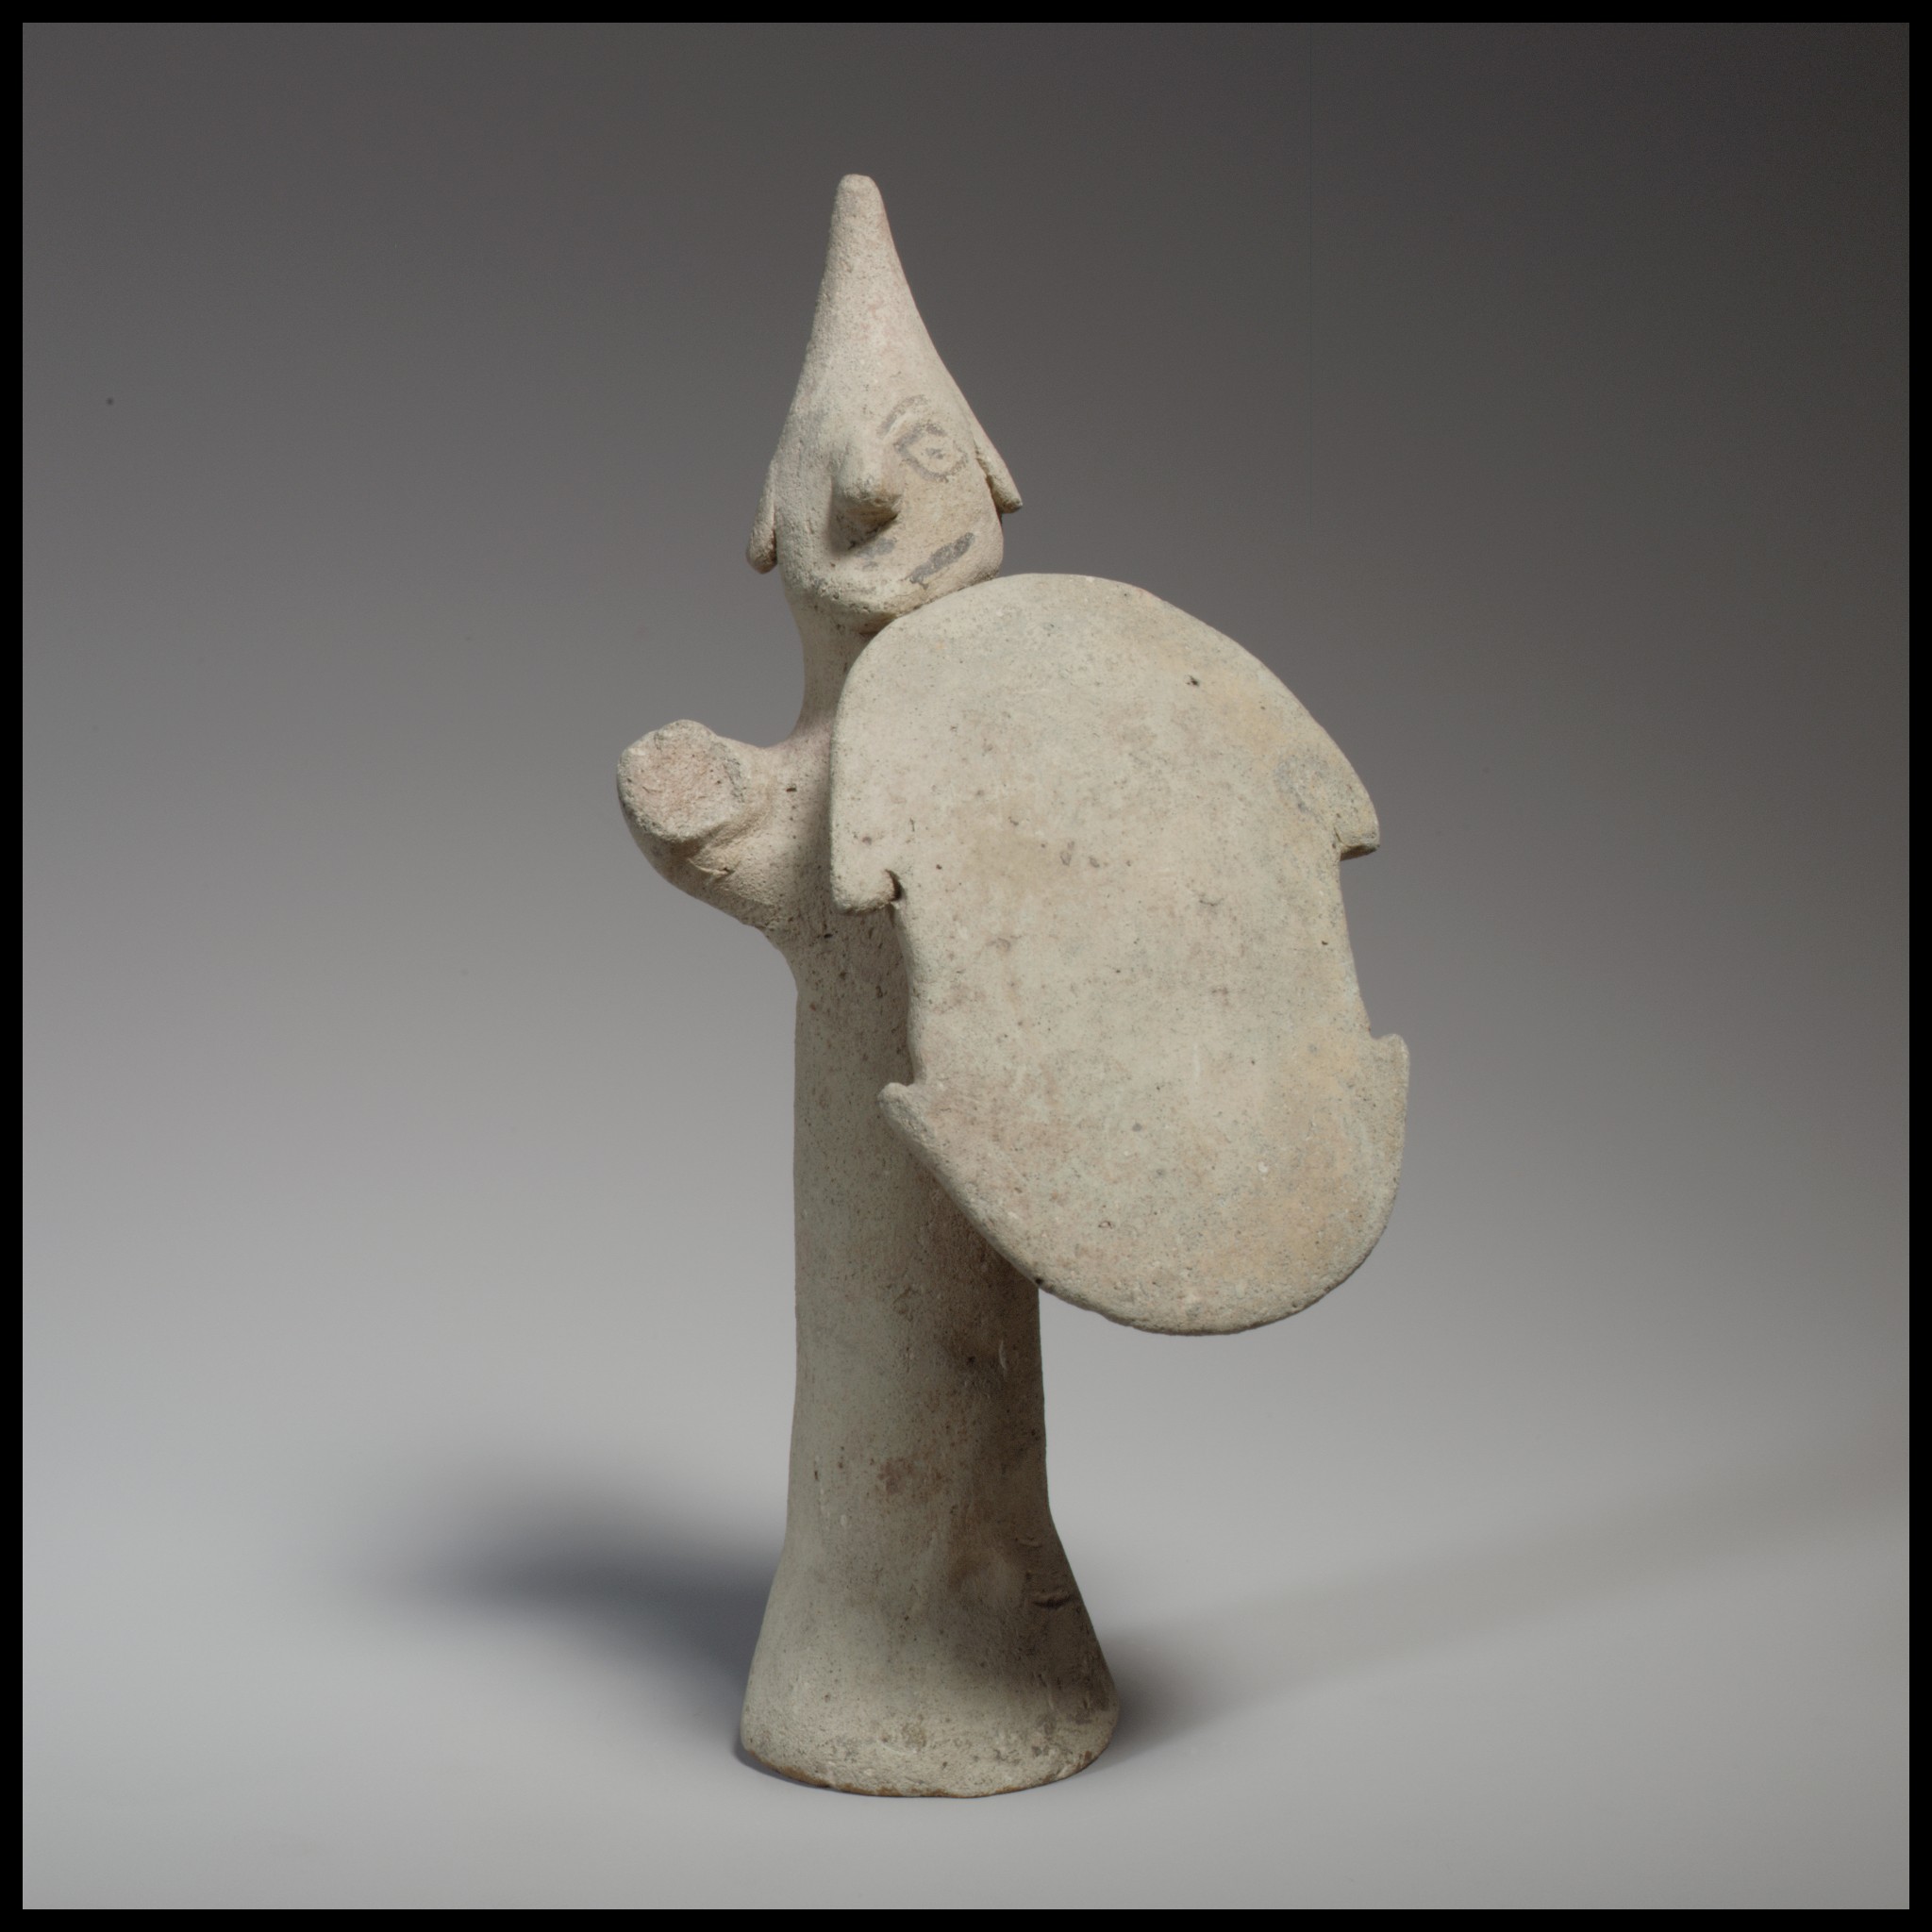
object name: statuette of a warrior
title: Shield bearer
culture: cypriot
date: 600-480 BCE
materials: terracotta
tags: shields,men